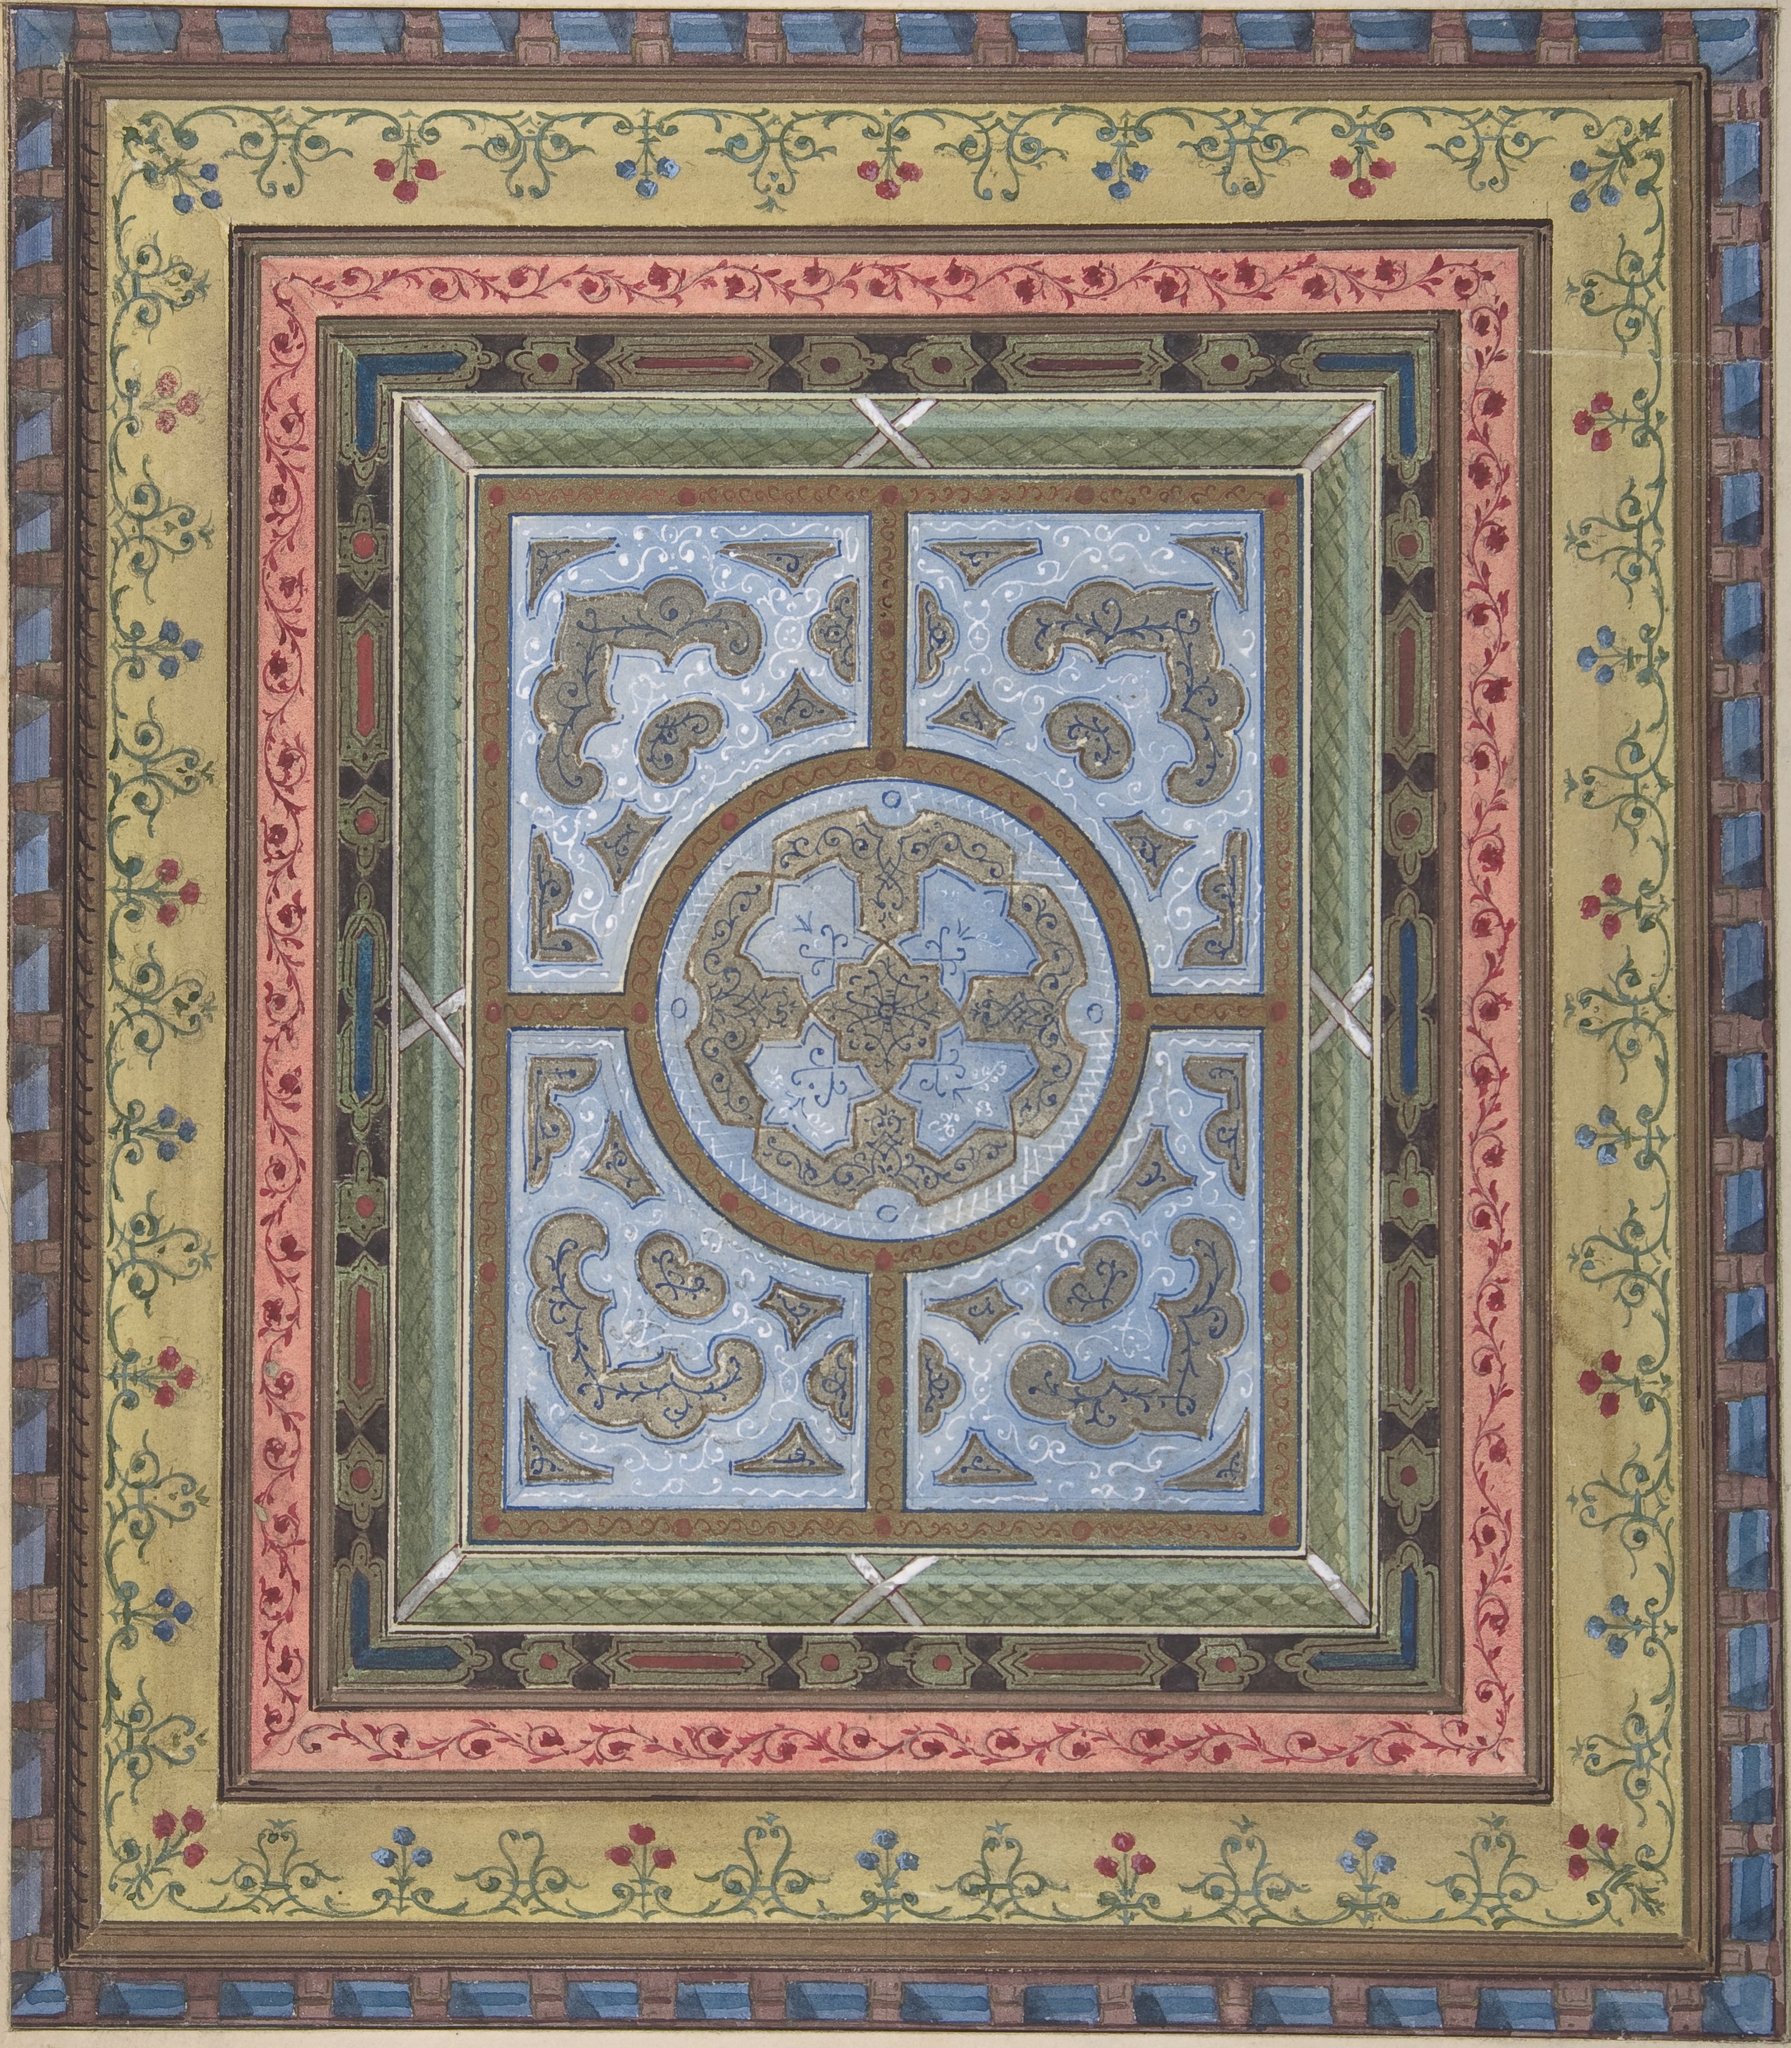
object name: drawing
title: Design for Ceiling with Plant and Arabesque Decoration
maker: charles monblond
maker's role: artist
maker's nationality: french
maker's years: 1800-1900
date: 1801-1900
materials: gilt, watercolor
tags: ceilings